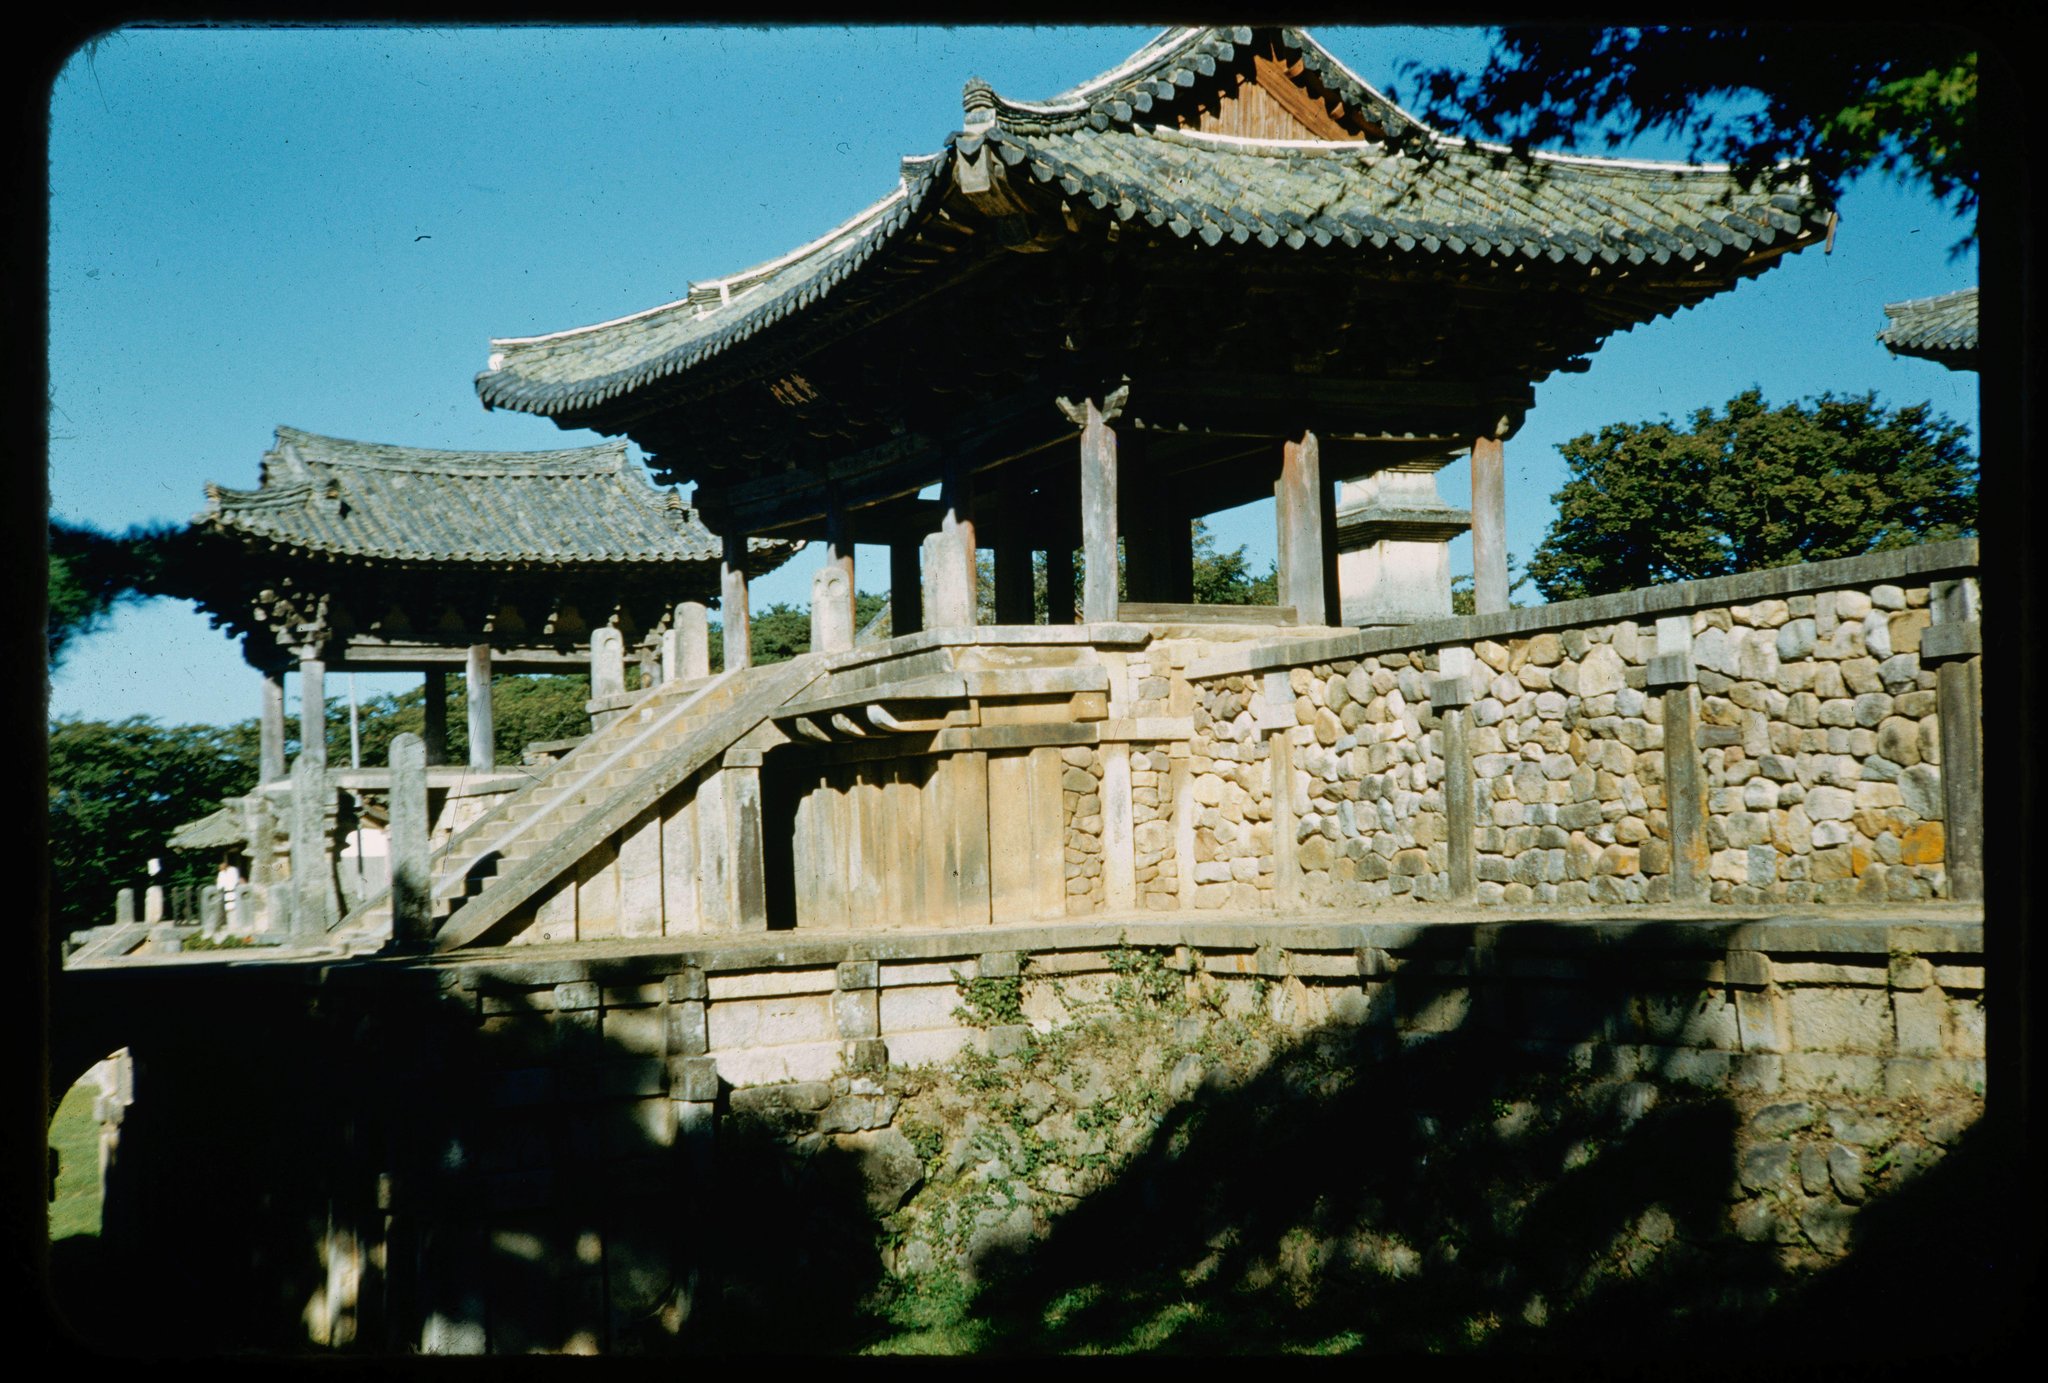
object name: color slide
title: Bukkuksa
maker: david ketel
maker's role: diplomaat, sinoloog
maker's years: 1913-2008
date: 1952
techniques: slide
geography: korea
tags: united nations